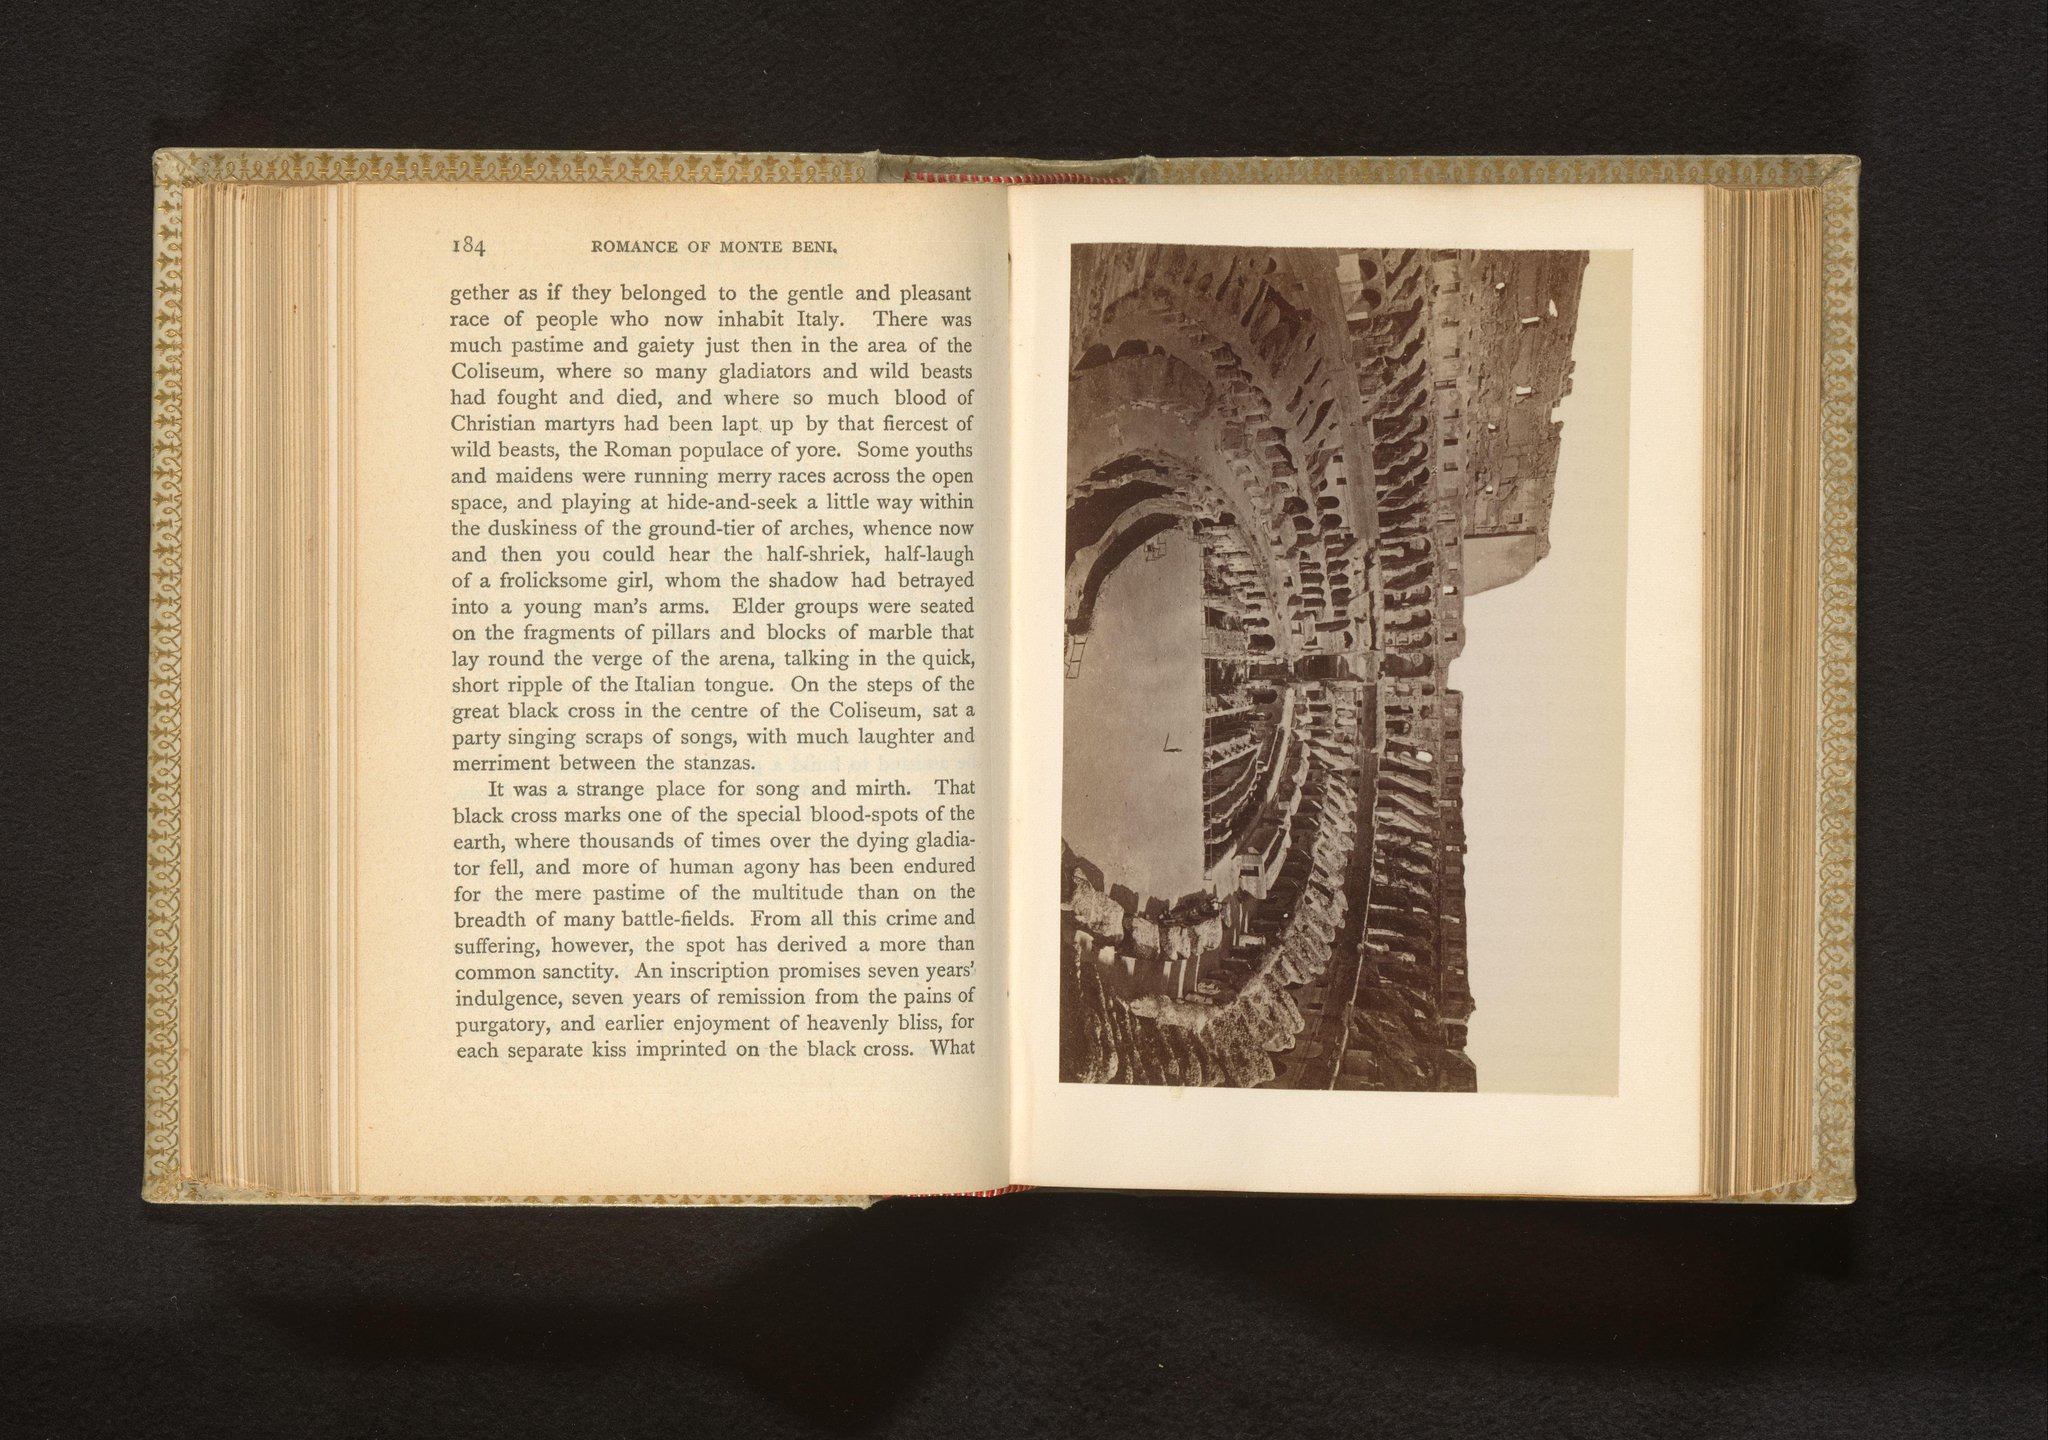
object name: photograph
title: Interieur van het Colosseum in Rome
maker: Anonymous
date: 1850-1860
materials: photographic support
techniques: albumen print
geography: colosseum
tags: theatre (building) - aa - open-air performances